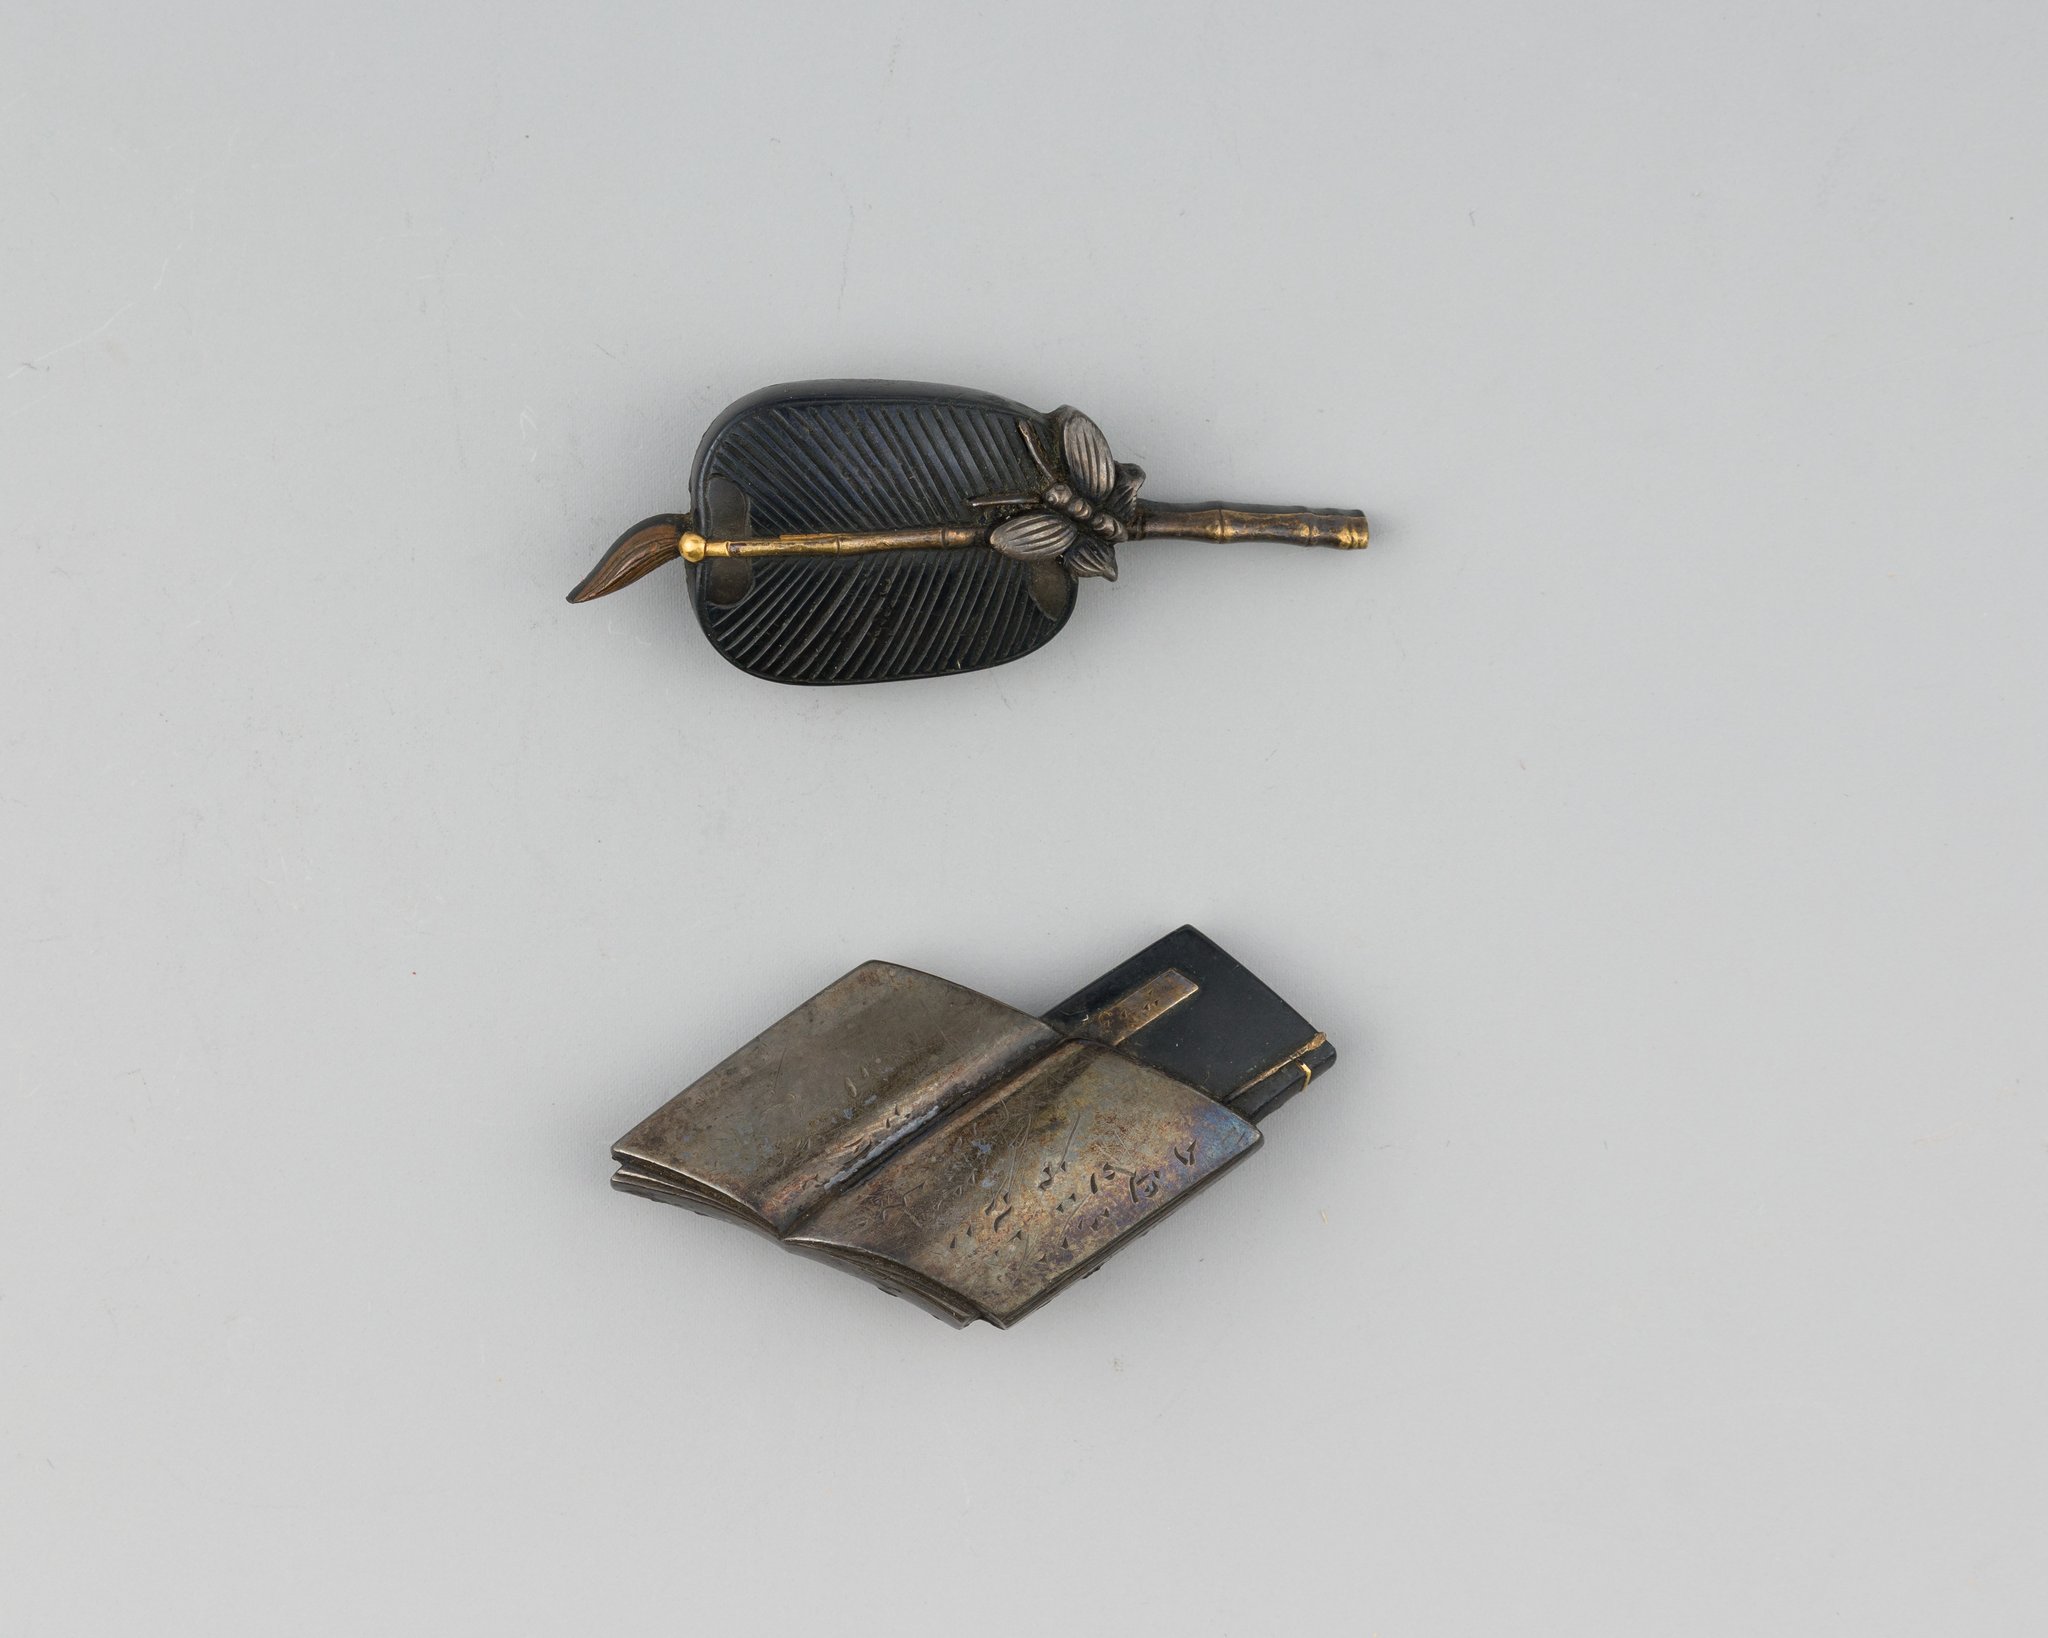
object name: pair of sword grip ornament menuki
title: Pair of Sword-Grip Ornaments (Menuki)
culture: japanese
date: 1701-1800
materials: copper, gold alloy, gold, silver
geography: japan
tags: butterflies